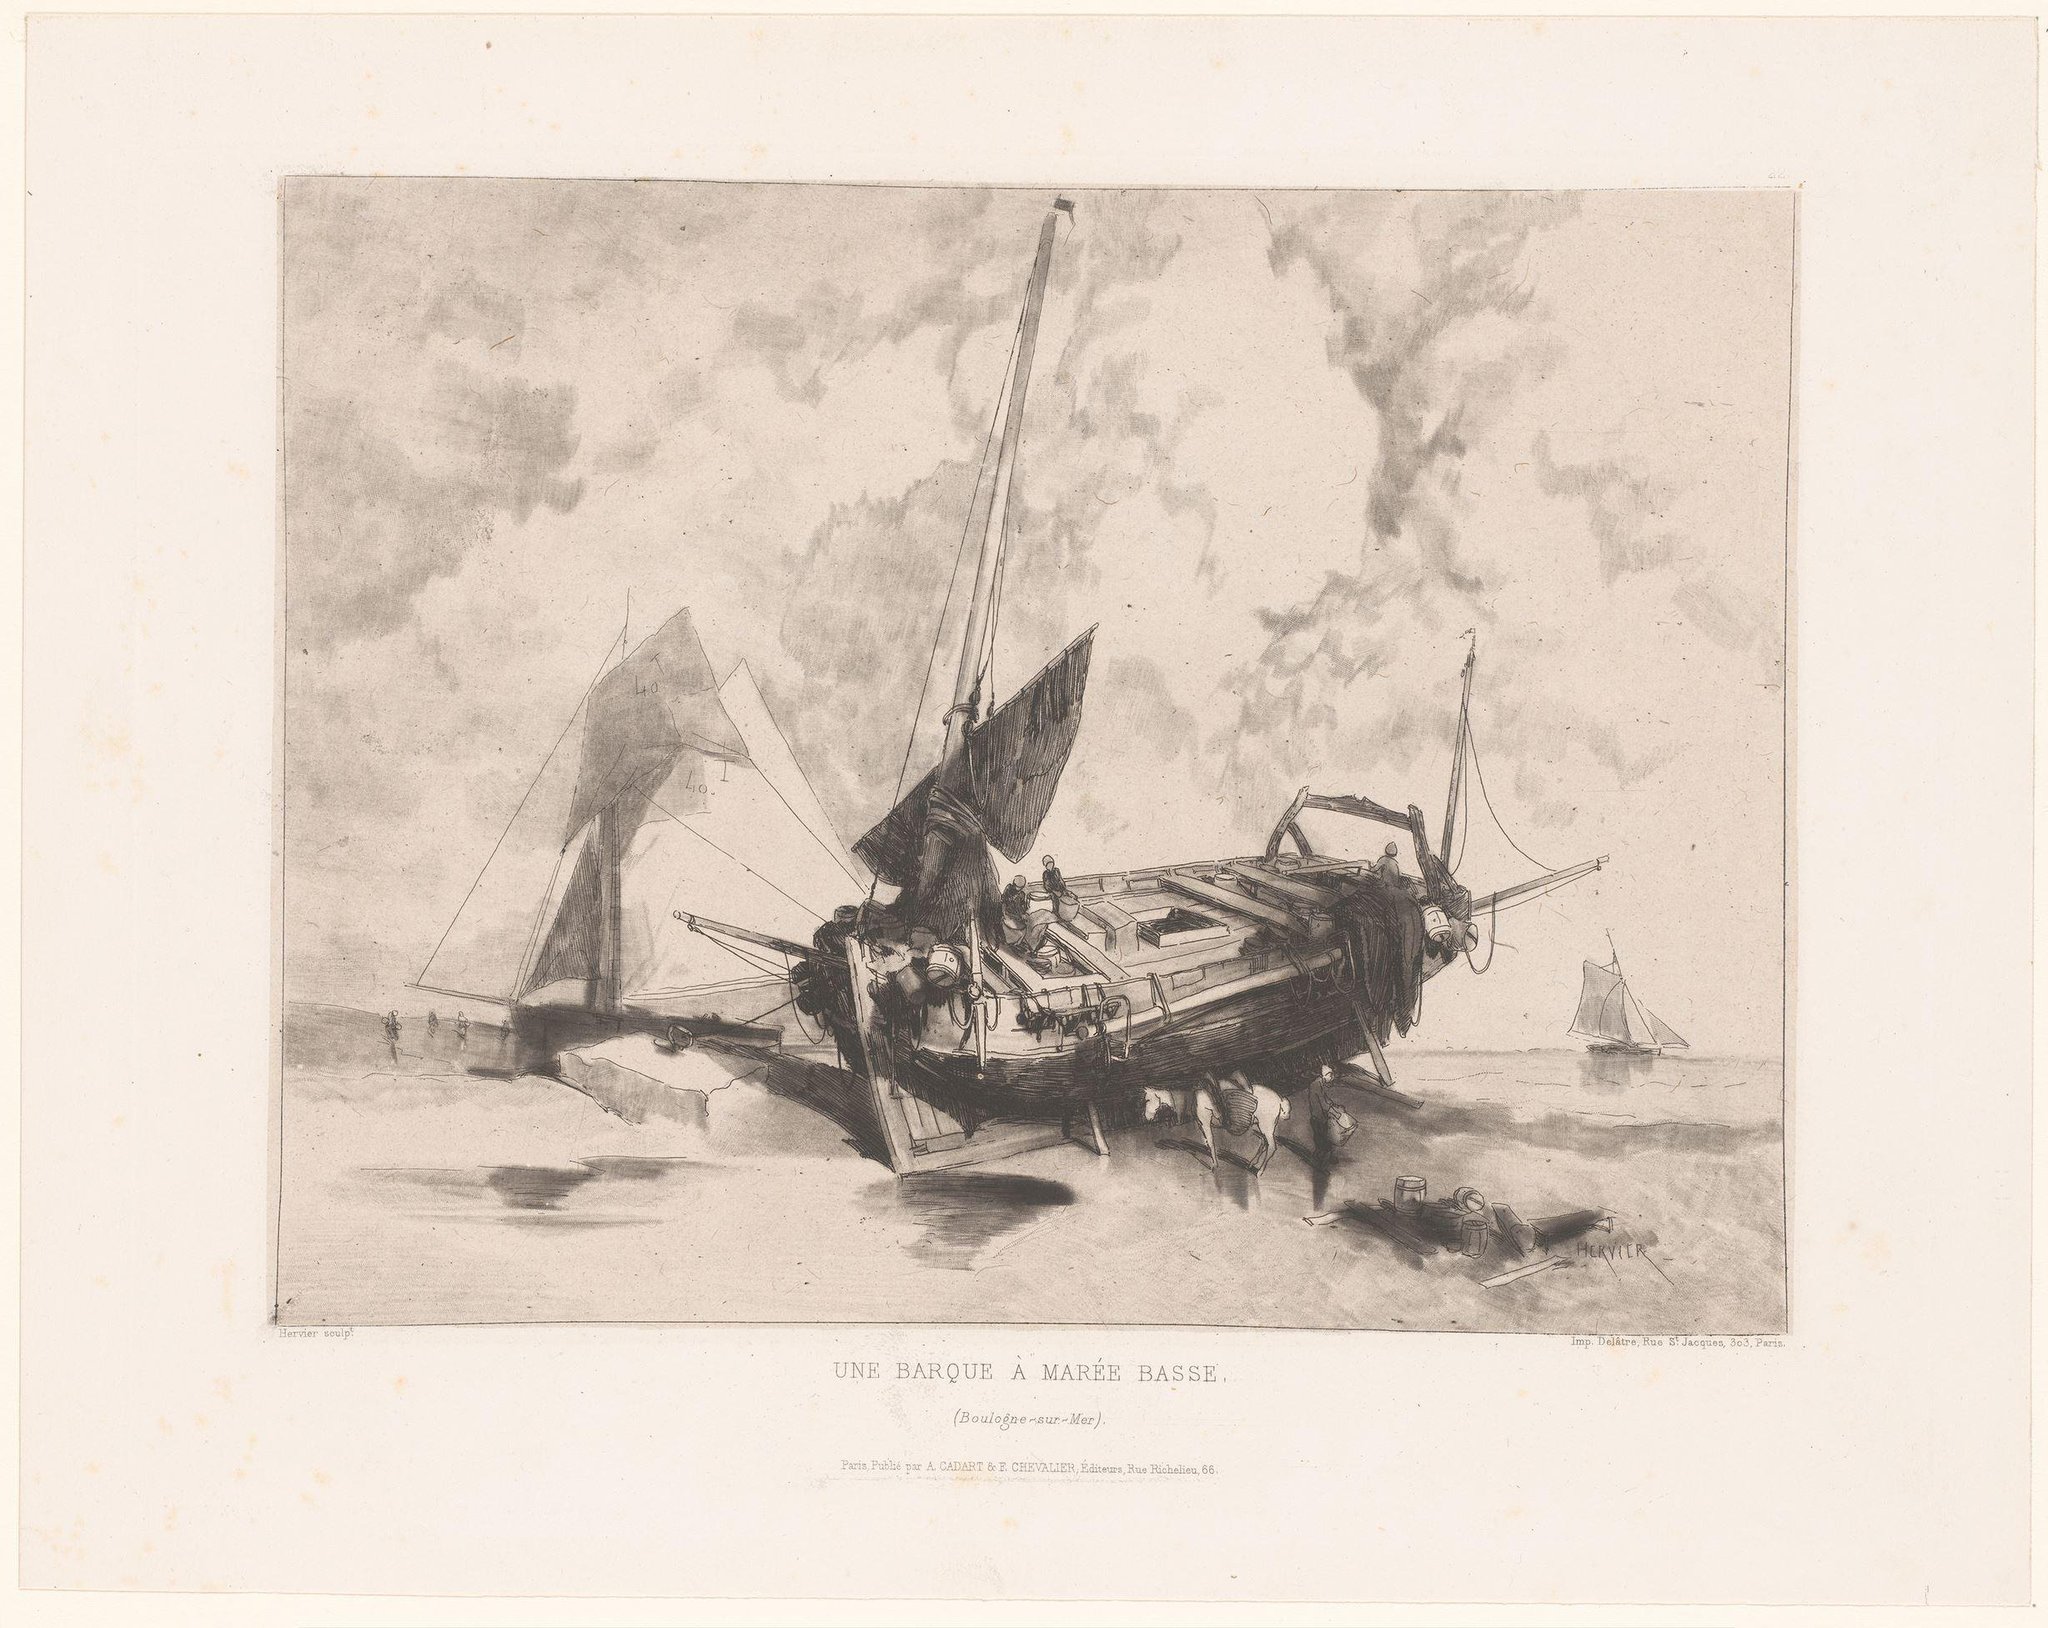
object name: print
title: Boot op het strand bij eb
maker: louis-adolphe hervier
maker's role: draughtsman, painter, print maker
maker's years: 1818-1879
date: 1863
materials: paper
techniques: etching, roulette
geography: paris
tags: sailing-ship, sailing-boat, beach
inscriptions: collector's mark: Lugt 2228, collector's mark: Lugt 2760